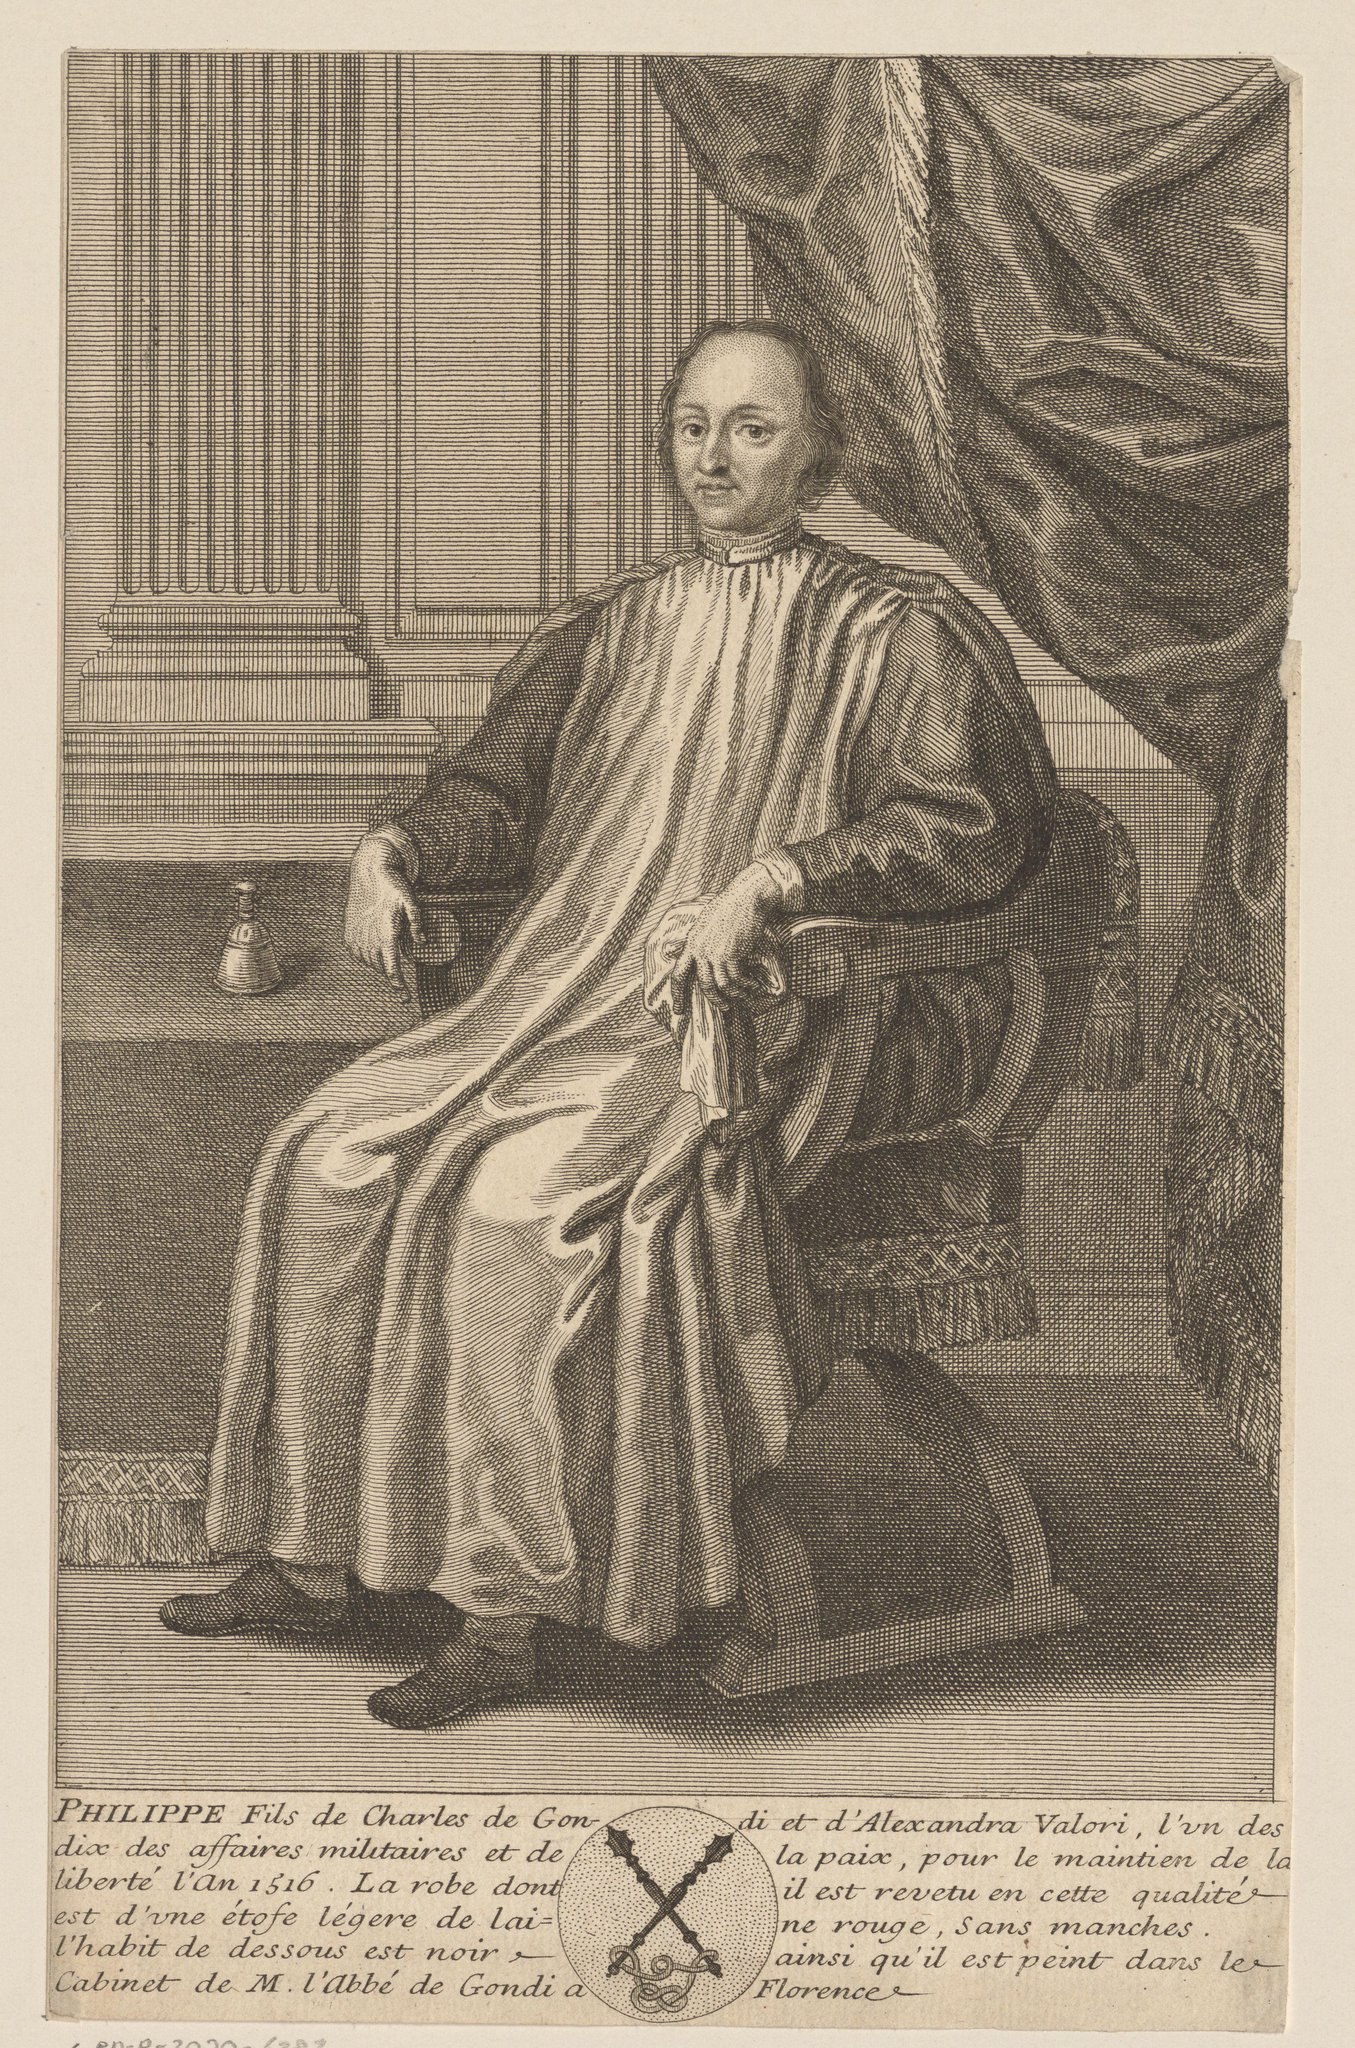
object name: book illustration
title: Portret van Filippo Emanuele di Gondi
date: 1705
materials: paper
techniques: engraving, etching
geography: paris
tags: historical persons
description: Prent uit: Corbinelli, Jean de. Histoire genealogique de la maison de Gondi. Parijs: Jean-Baptiste Coignard, 1705.